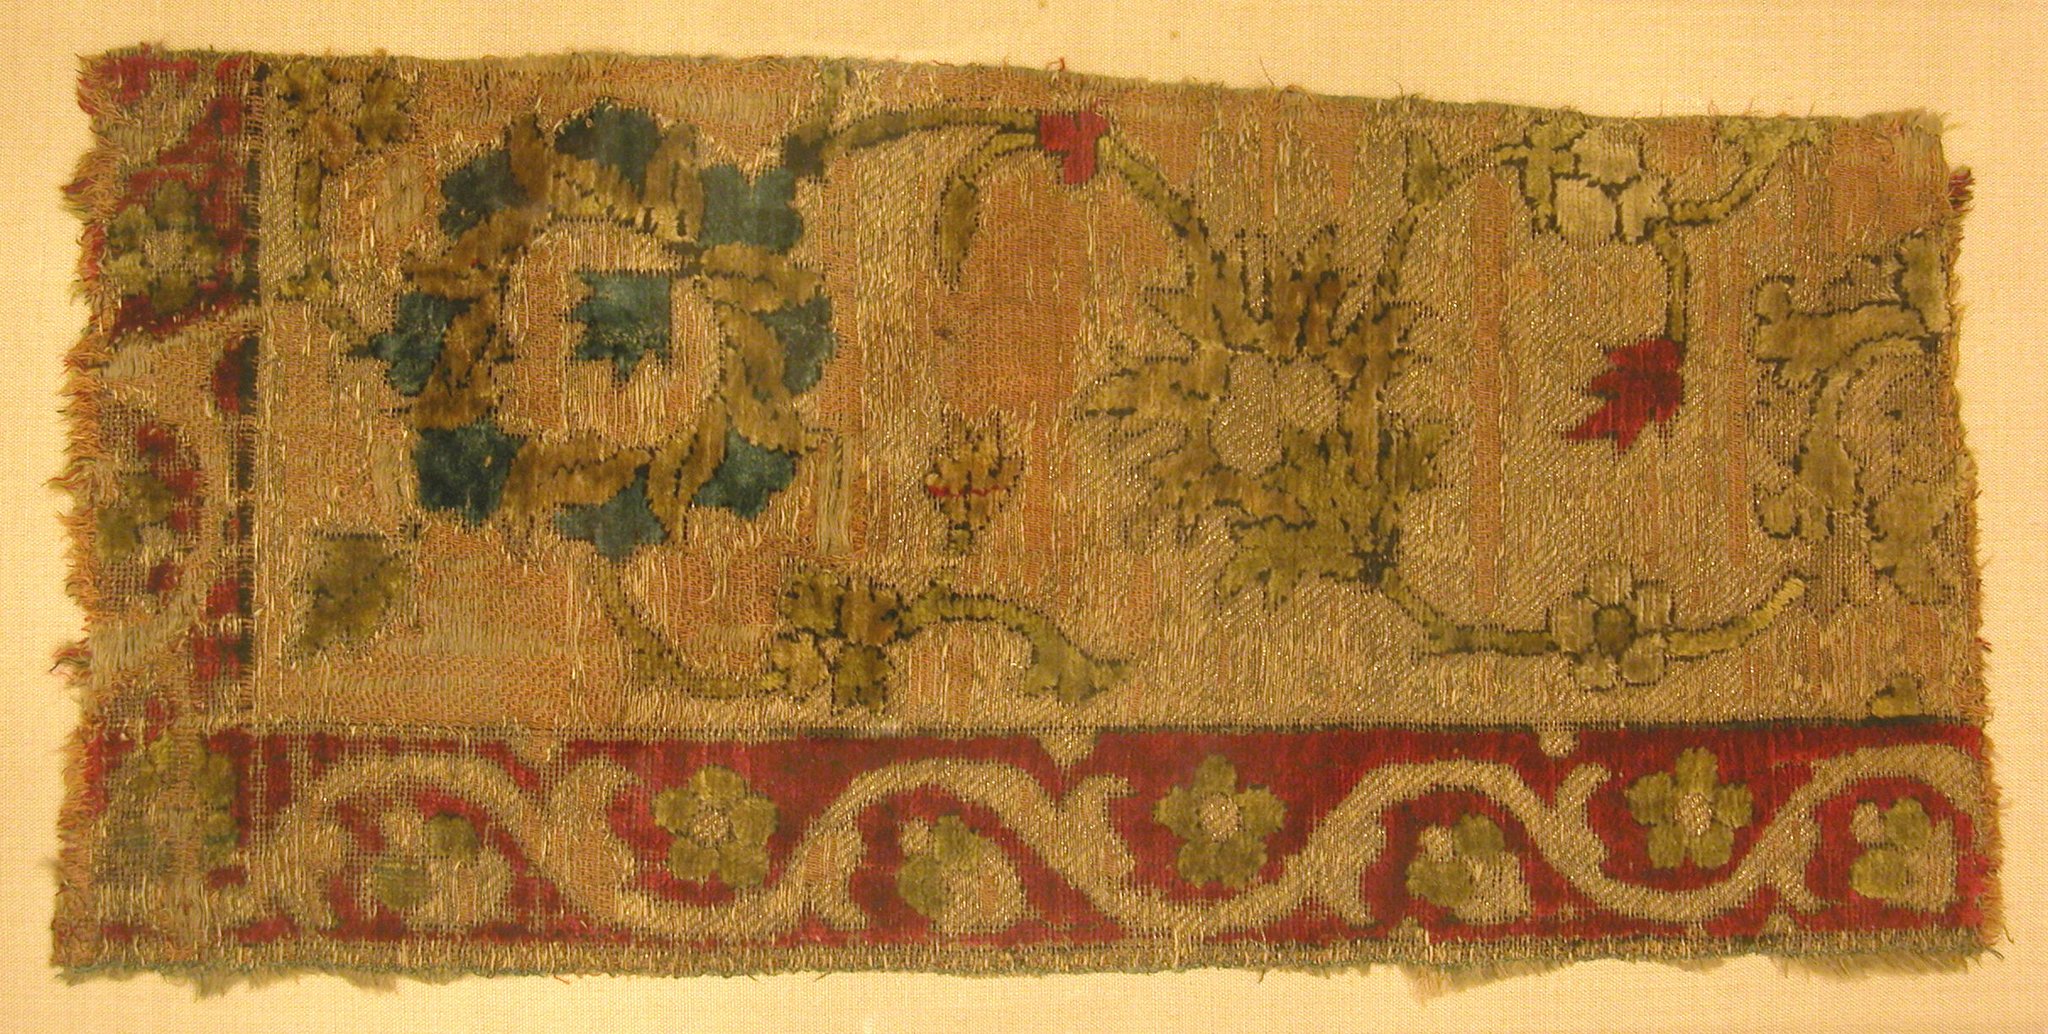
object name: fragment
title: Velvet Fragment with Scrolling Floral Vine Design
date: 1501-1600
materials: metal thread, silk, velvet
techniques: brocade, cutting, voiding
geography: iran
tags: flowers